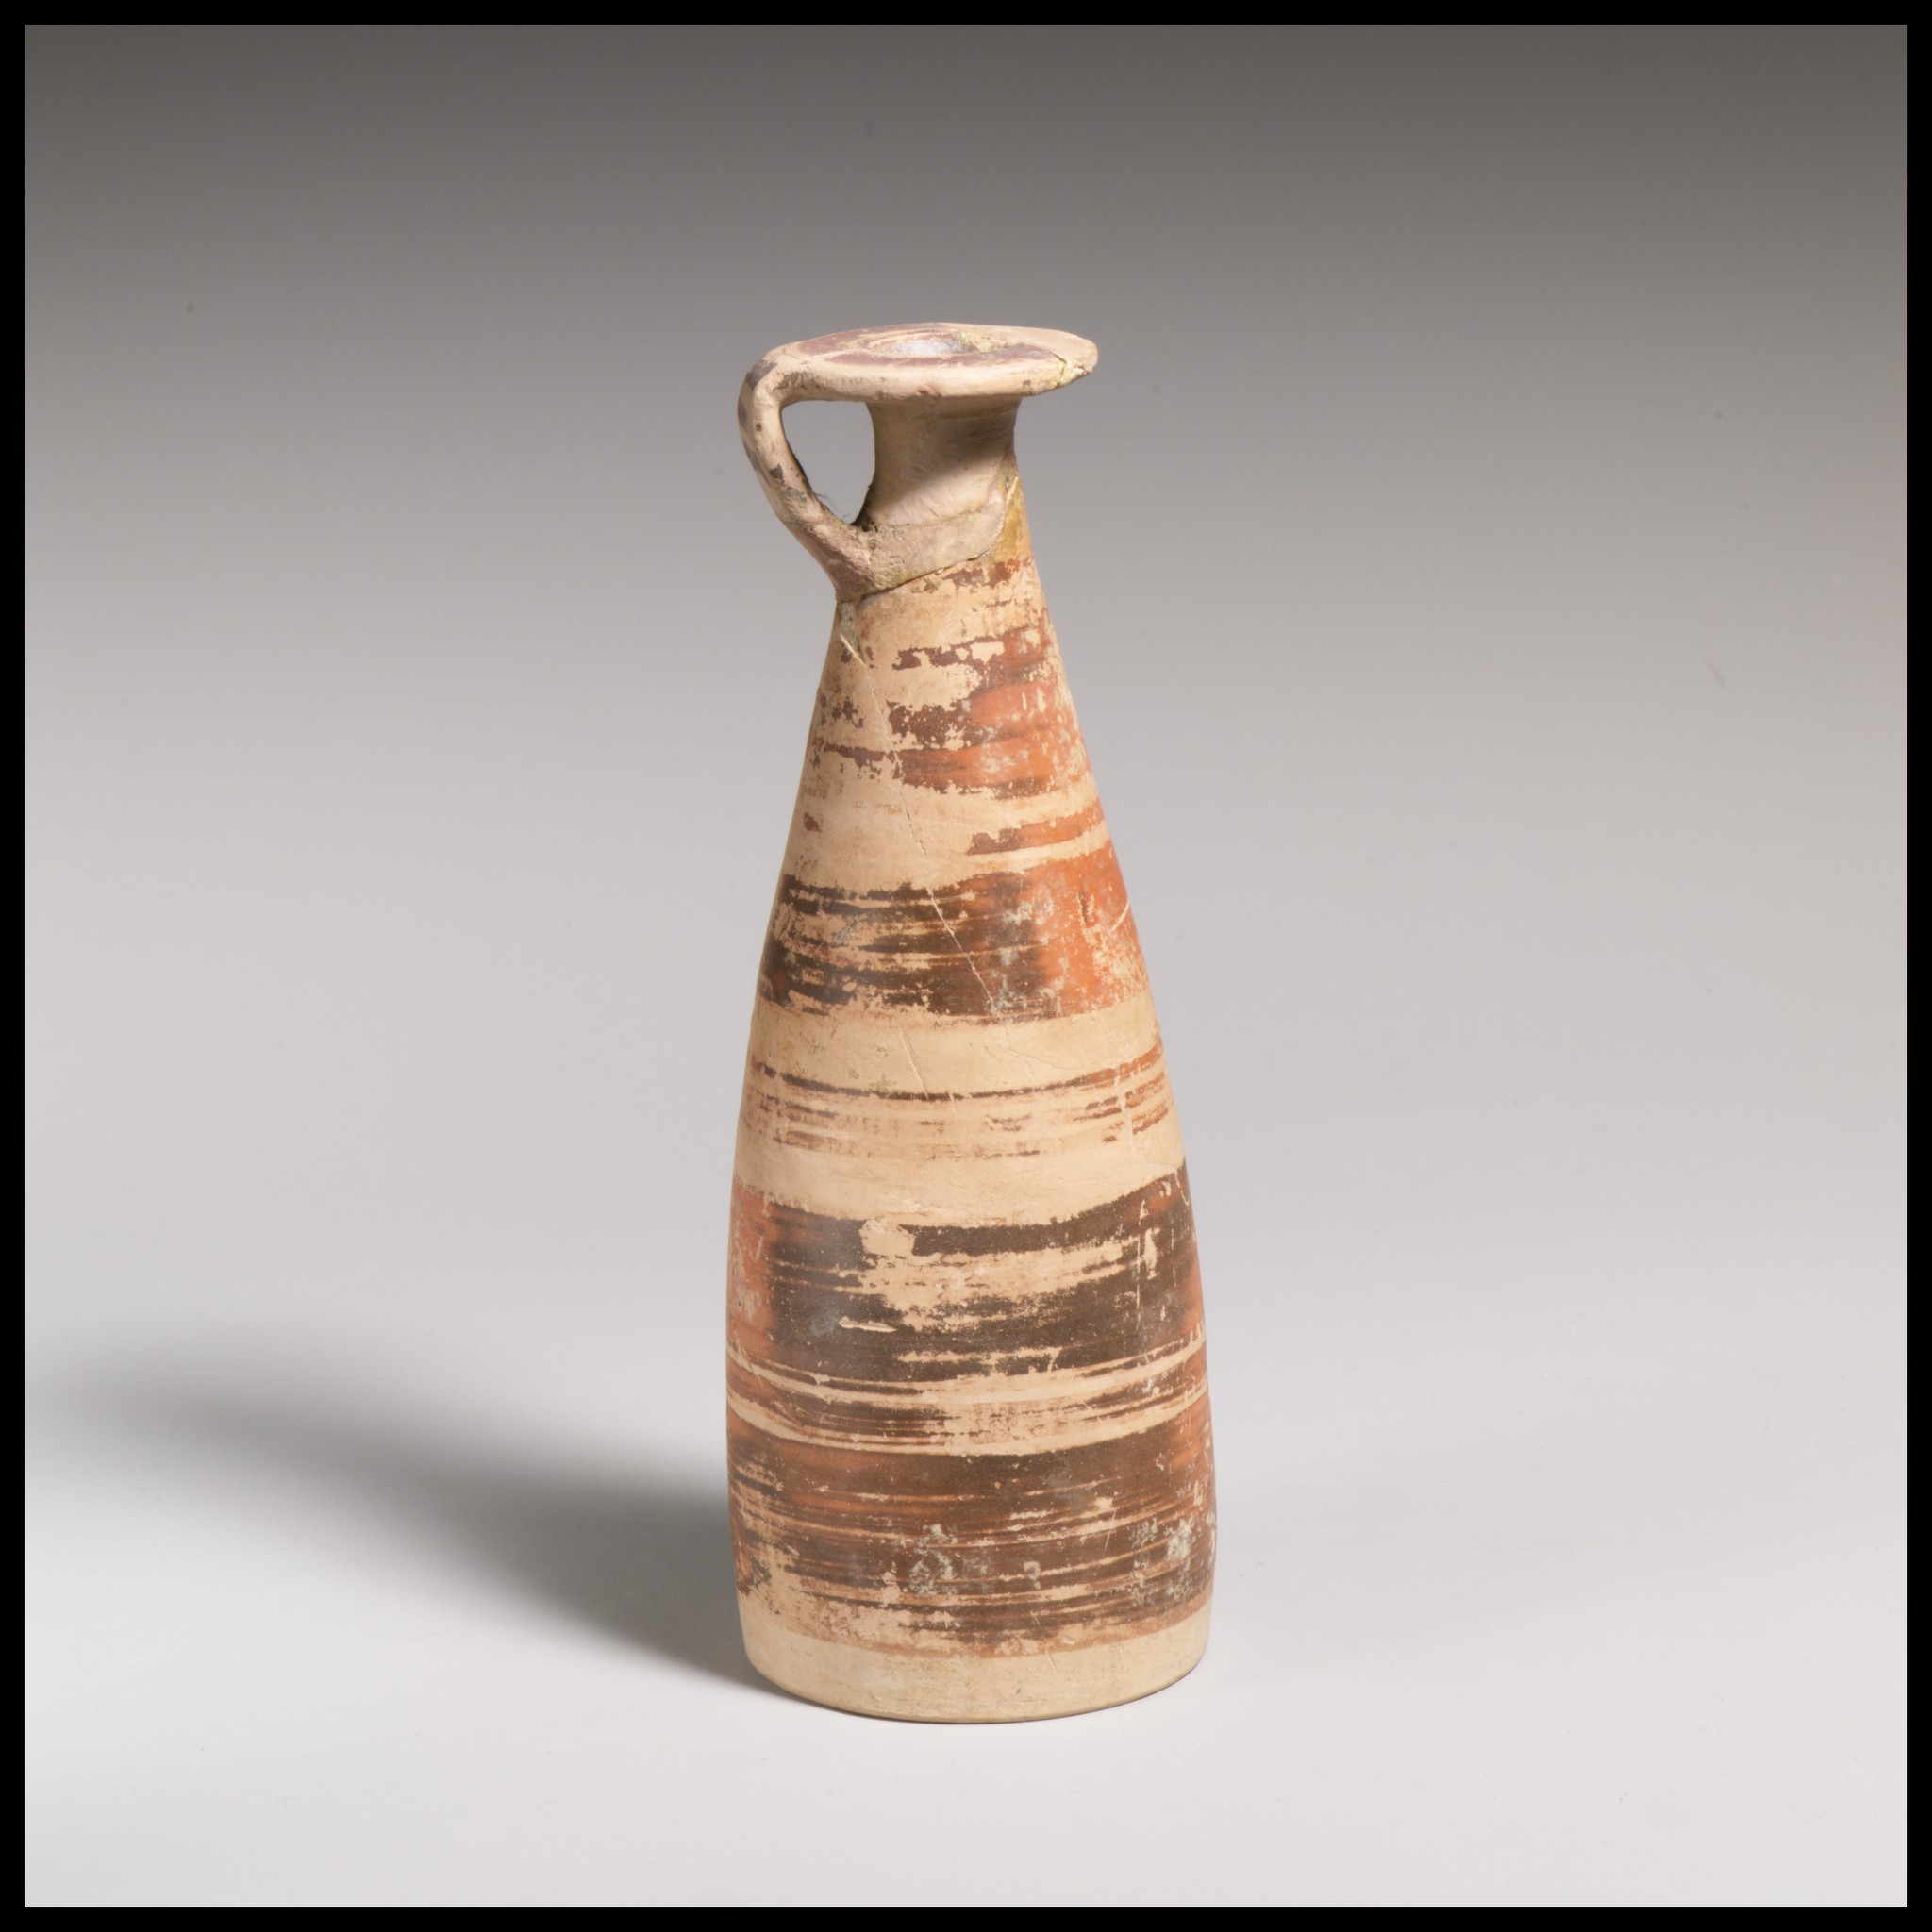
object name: alabastron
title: Terracotta alabastron (perfume vase)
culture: etruscan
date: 600-568 BCE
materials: terracotta